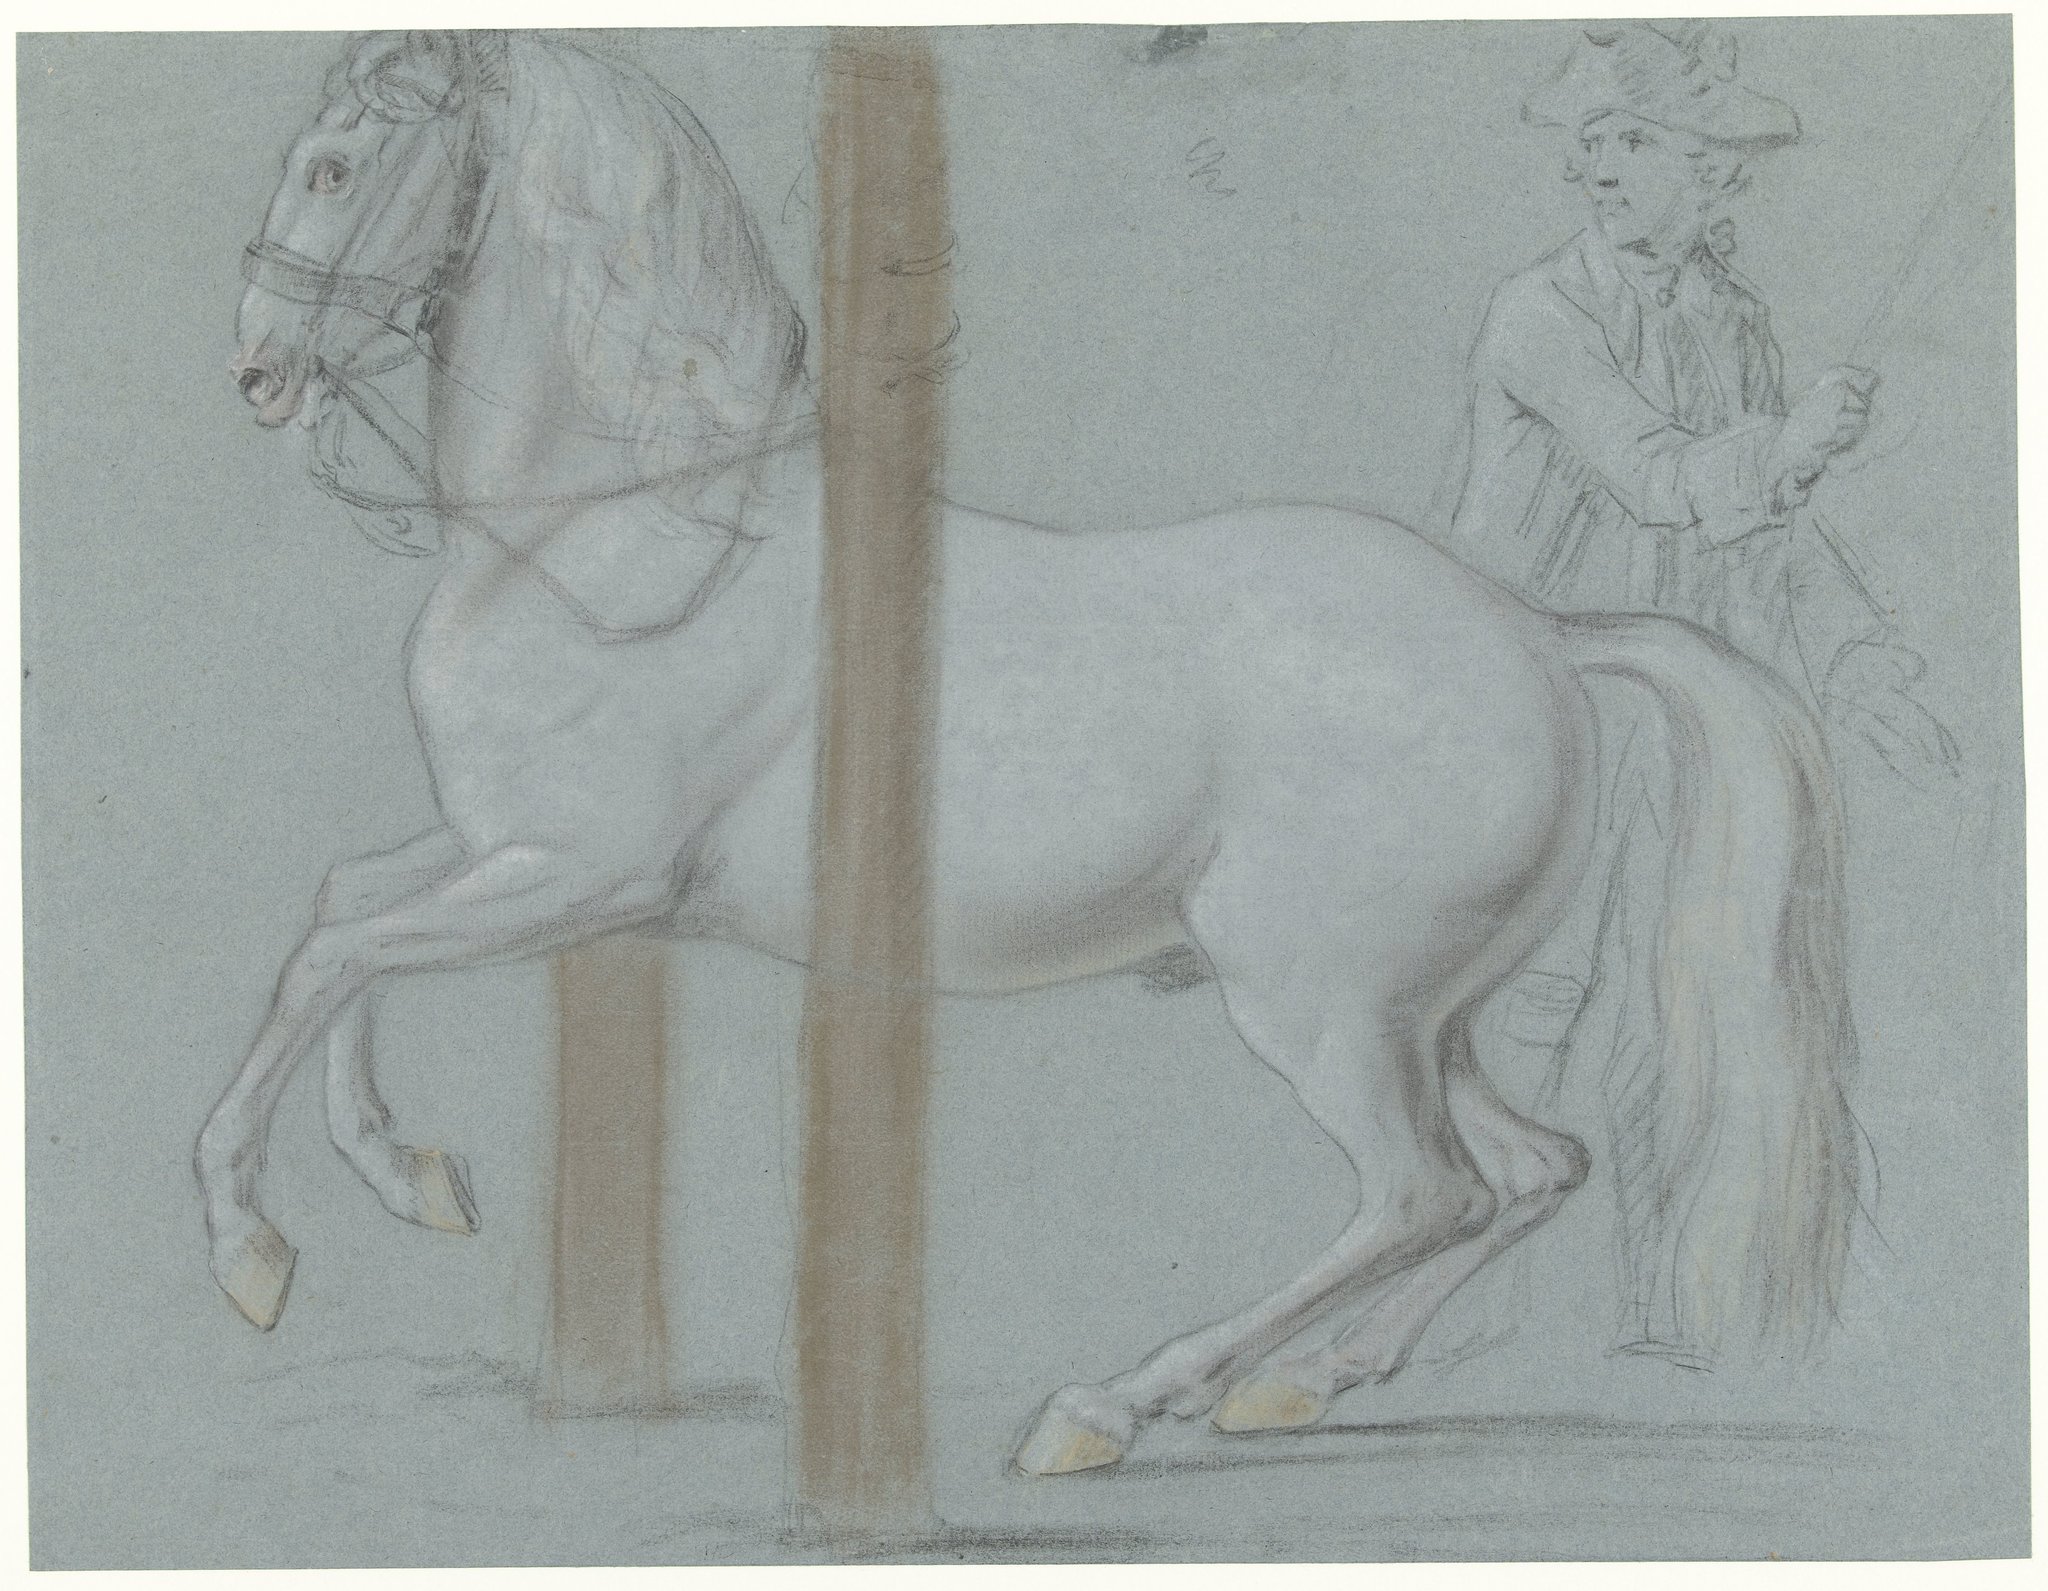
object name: drawing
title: Paardendressuur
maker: charles parrocel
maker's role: draughtsman, painter, print maker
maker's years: 1688-1752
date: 1698-1752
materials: chalk, paper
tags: circus animals, horses (circus performance), training of horses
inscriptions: collector's mark: Lugt 2228a